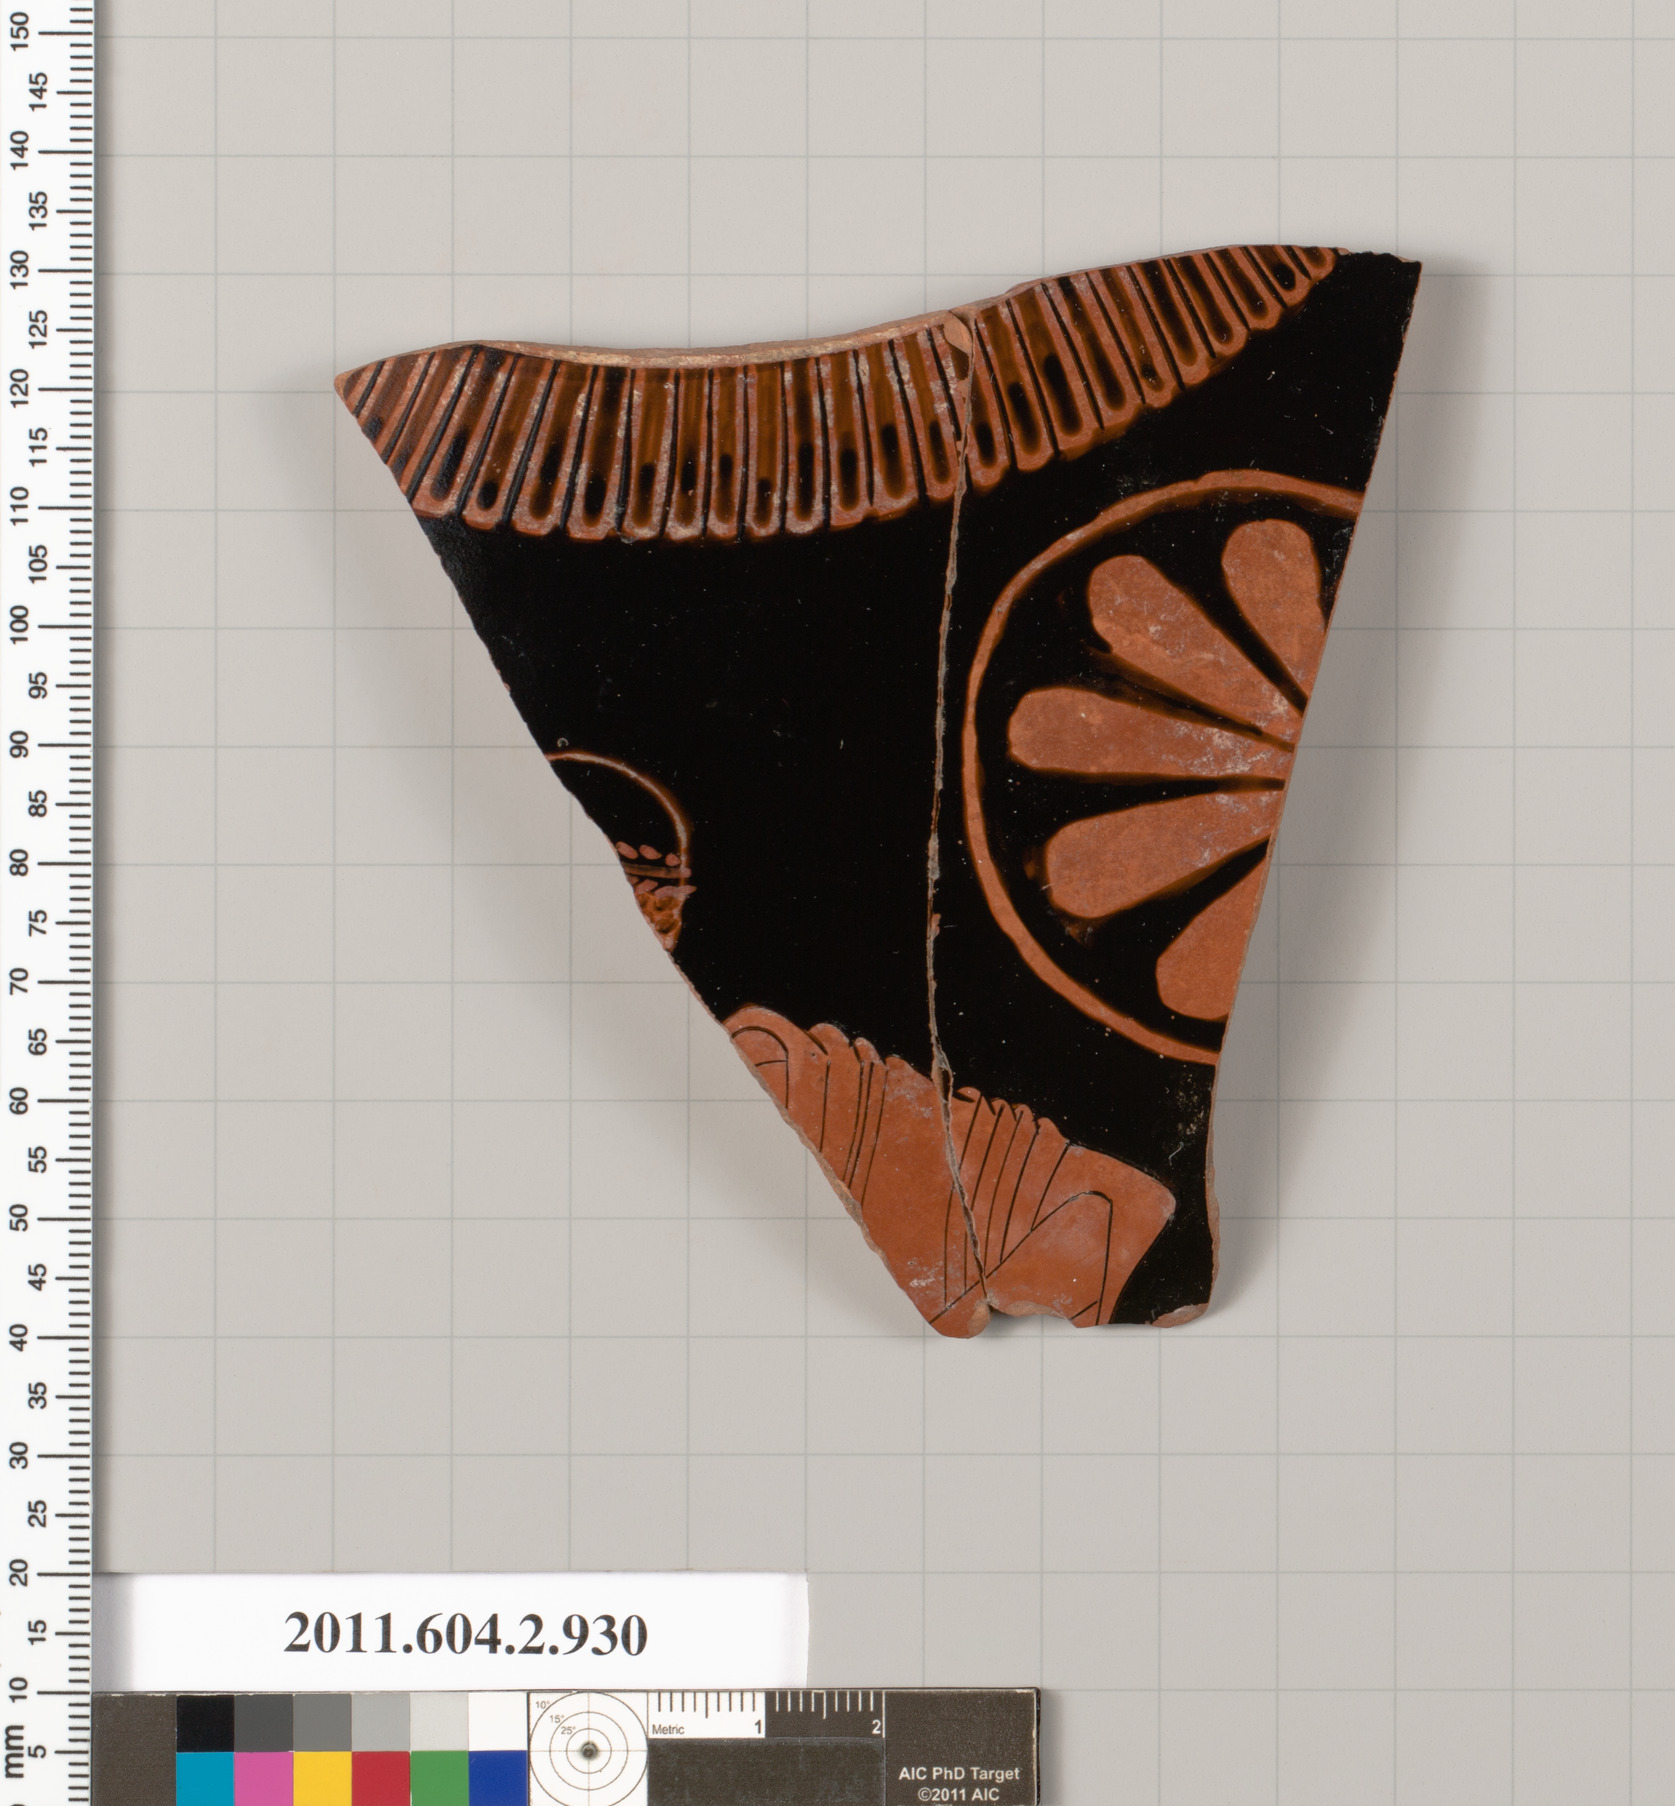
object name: kalpis fragment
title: Terracotta fragment of a hydria: kalpis (water jar)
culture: greek, attic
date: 480-470 BCE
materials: terracotta